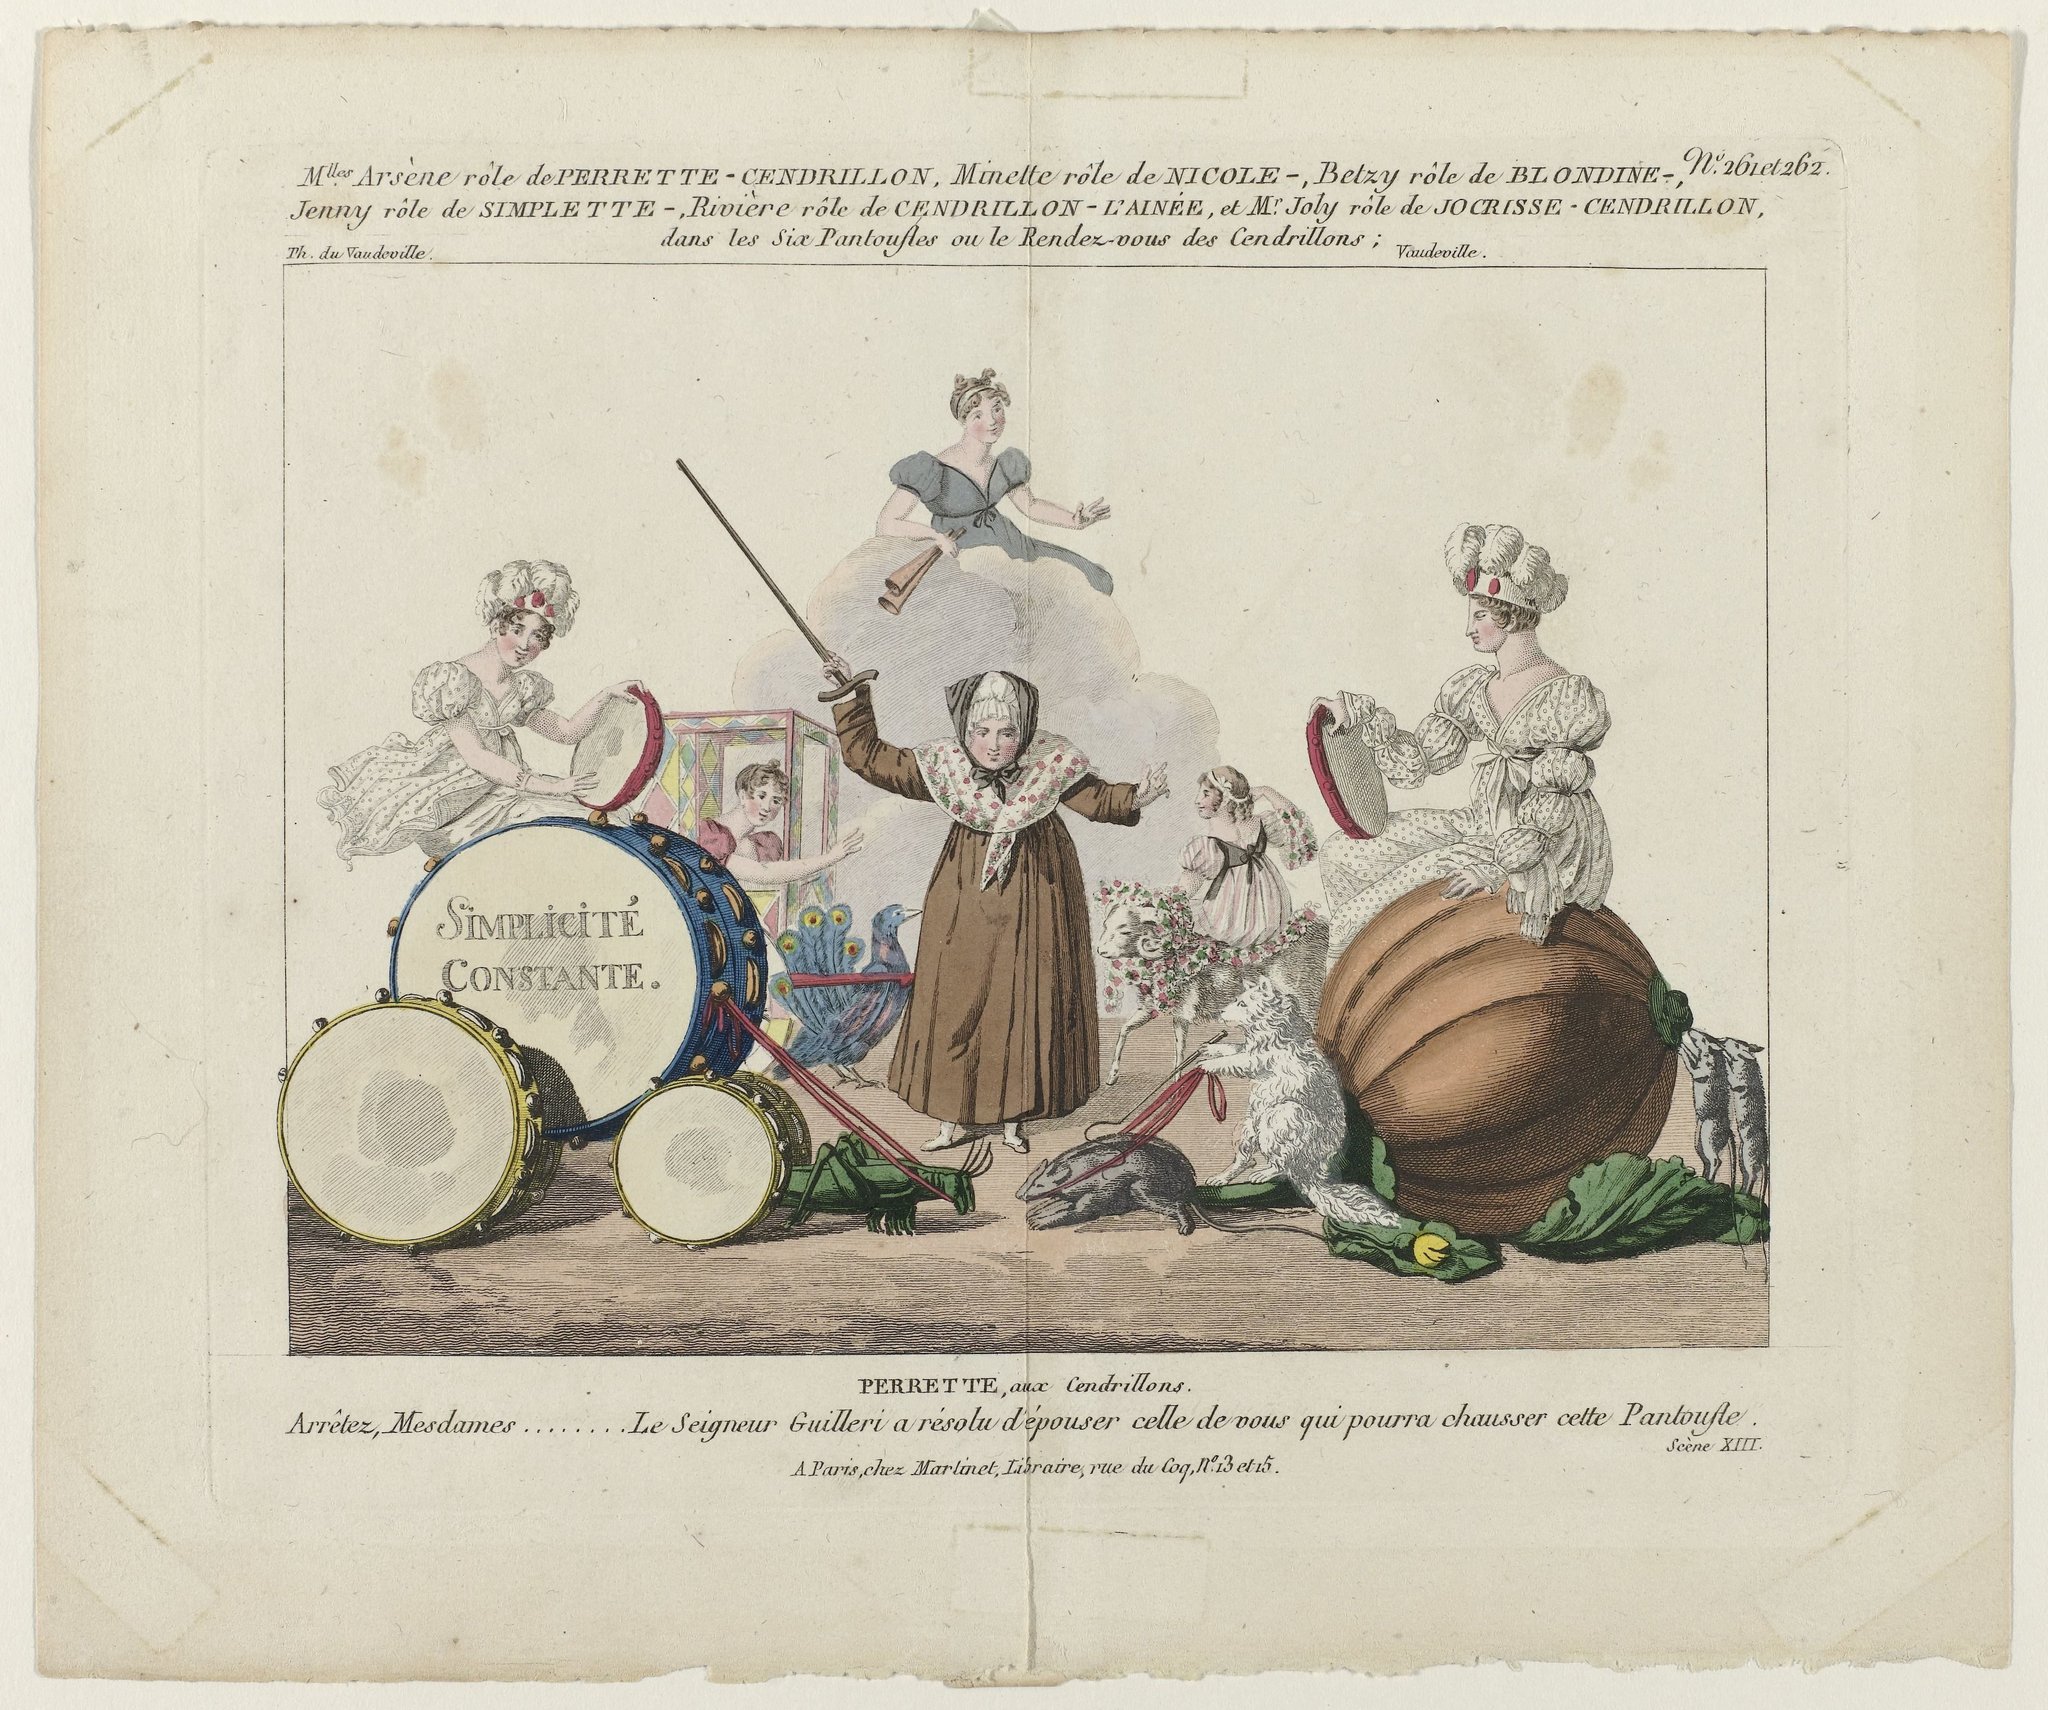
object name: fashion print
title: Perrette, aux Cendrillons, ca 1822, Scène XIII (8)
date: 1822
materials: paper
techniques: engraving, hand coloring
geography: paris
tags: fashion plates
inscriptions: caption: ‘PERRETTE, aux Cendrillons. Arrêtez, Mesdames...... Le Seigneur Guilleri a résolu d'épouser celle de vous qui pourra chausser cette Pantoufle. / Scène XIII.’, inscription: ‘M.lles Arsène rôle de PERRETTE-CENDRILLON, Minette rôle de NICOLE -, Betzy rôle de BLONDINE -, No. 261 et 262. Jenny rôle de SIMPLETTE -, Rivière rôle de CENDRILLON-L'AINÉE, et M.r Joly rôle de JOCRISSE - CENDRILLON, dans les six Pantoufles ou le Rendez-vous des Cendrillons; / Vaudeville.’, address: ‘A Paris, chez Martinet, Libraire, rue du Coq, No. 13 et 15.’